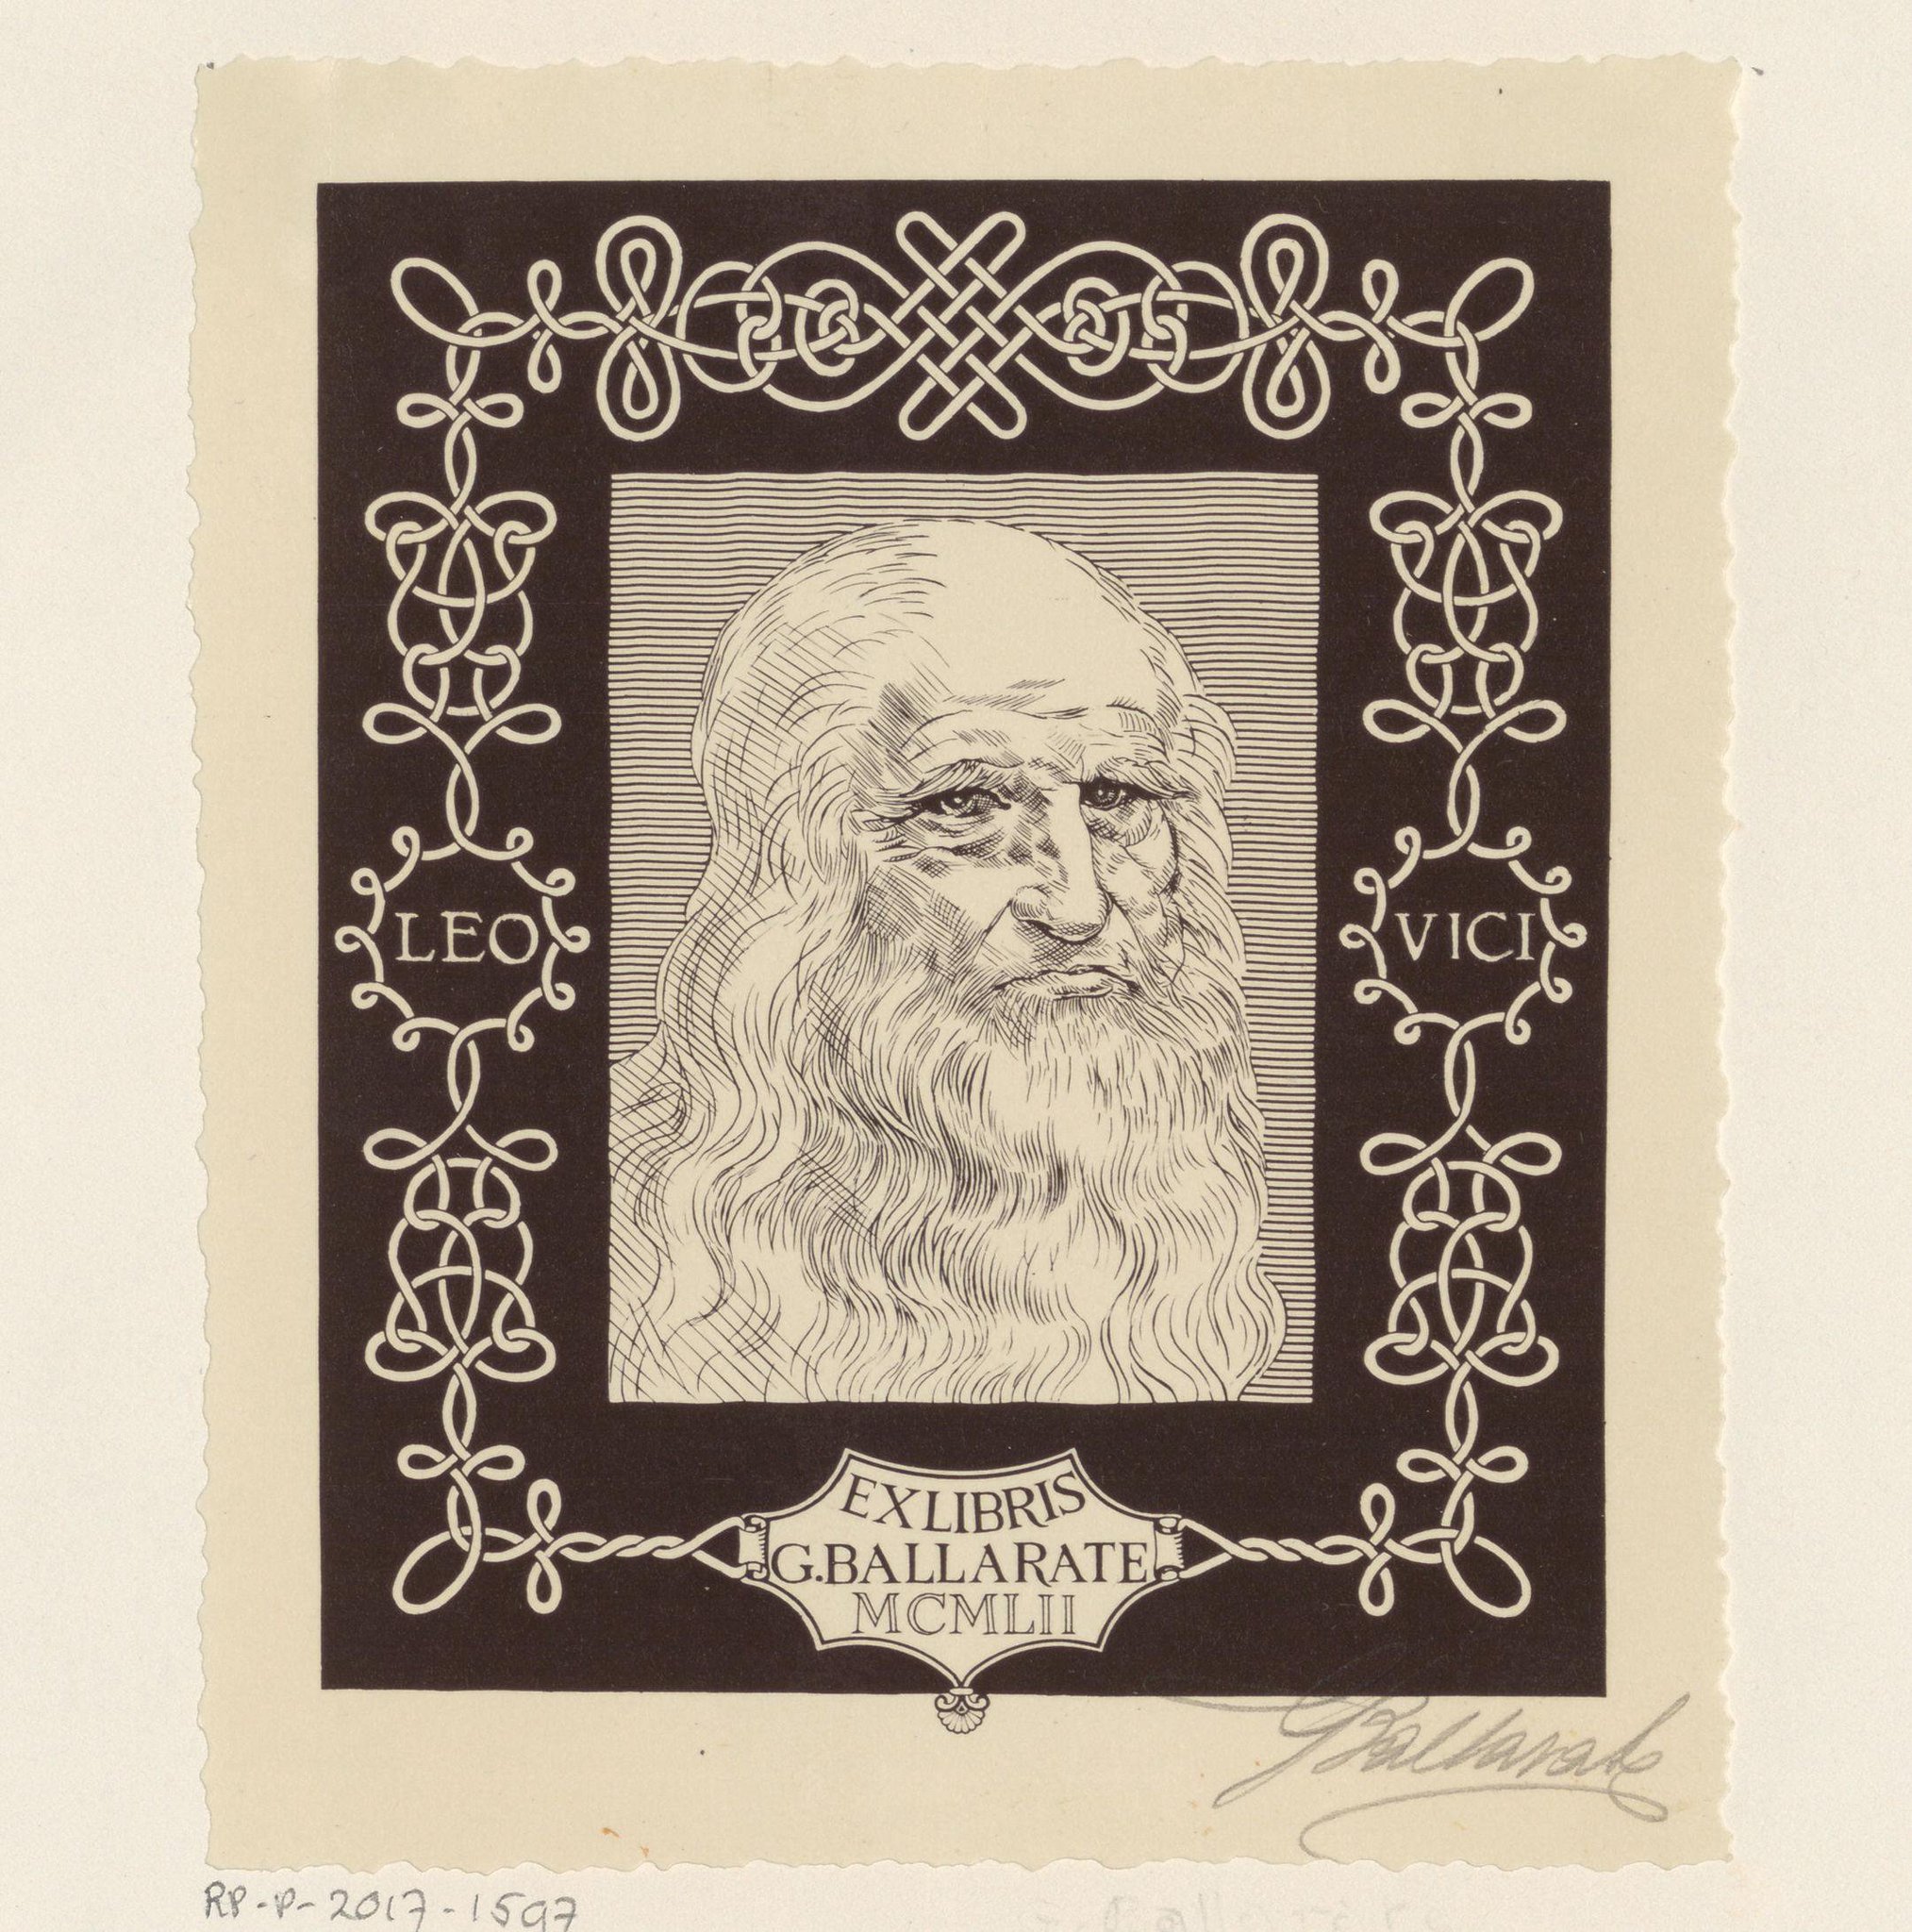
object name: bookplate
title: Ex libris van G. Ballarate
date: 1952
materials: paper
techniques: printing block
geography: italy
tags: gemma ballarate fiocchi, artist, leonardo da vinci, interlace ~ ornament, portrait, self-portrait of artist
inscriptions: signature: ‘G Ballarate’